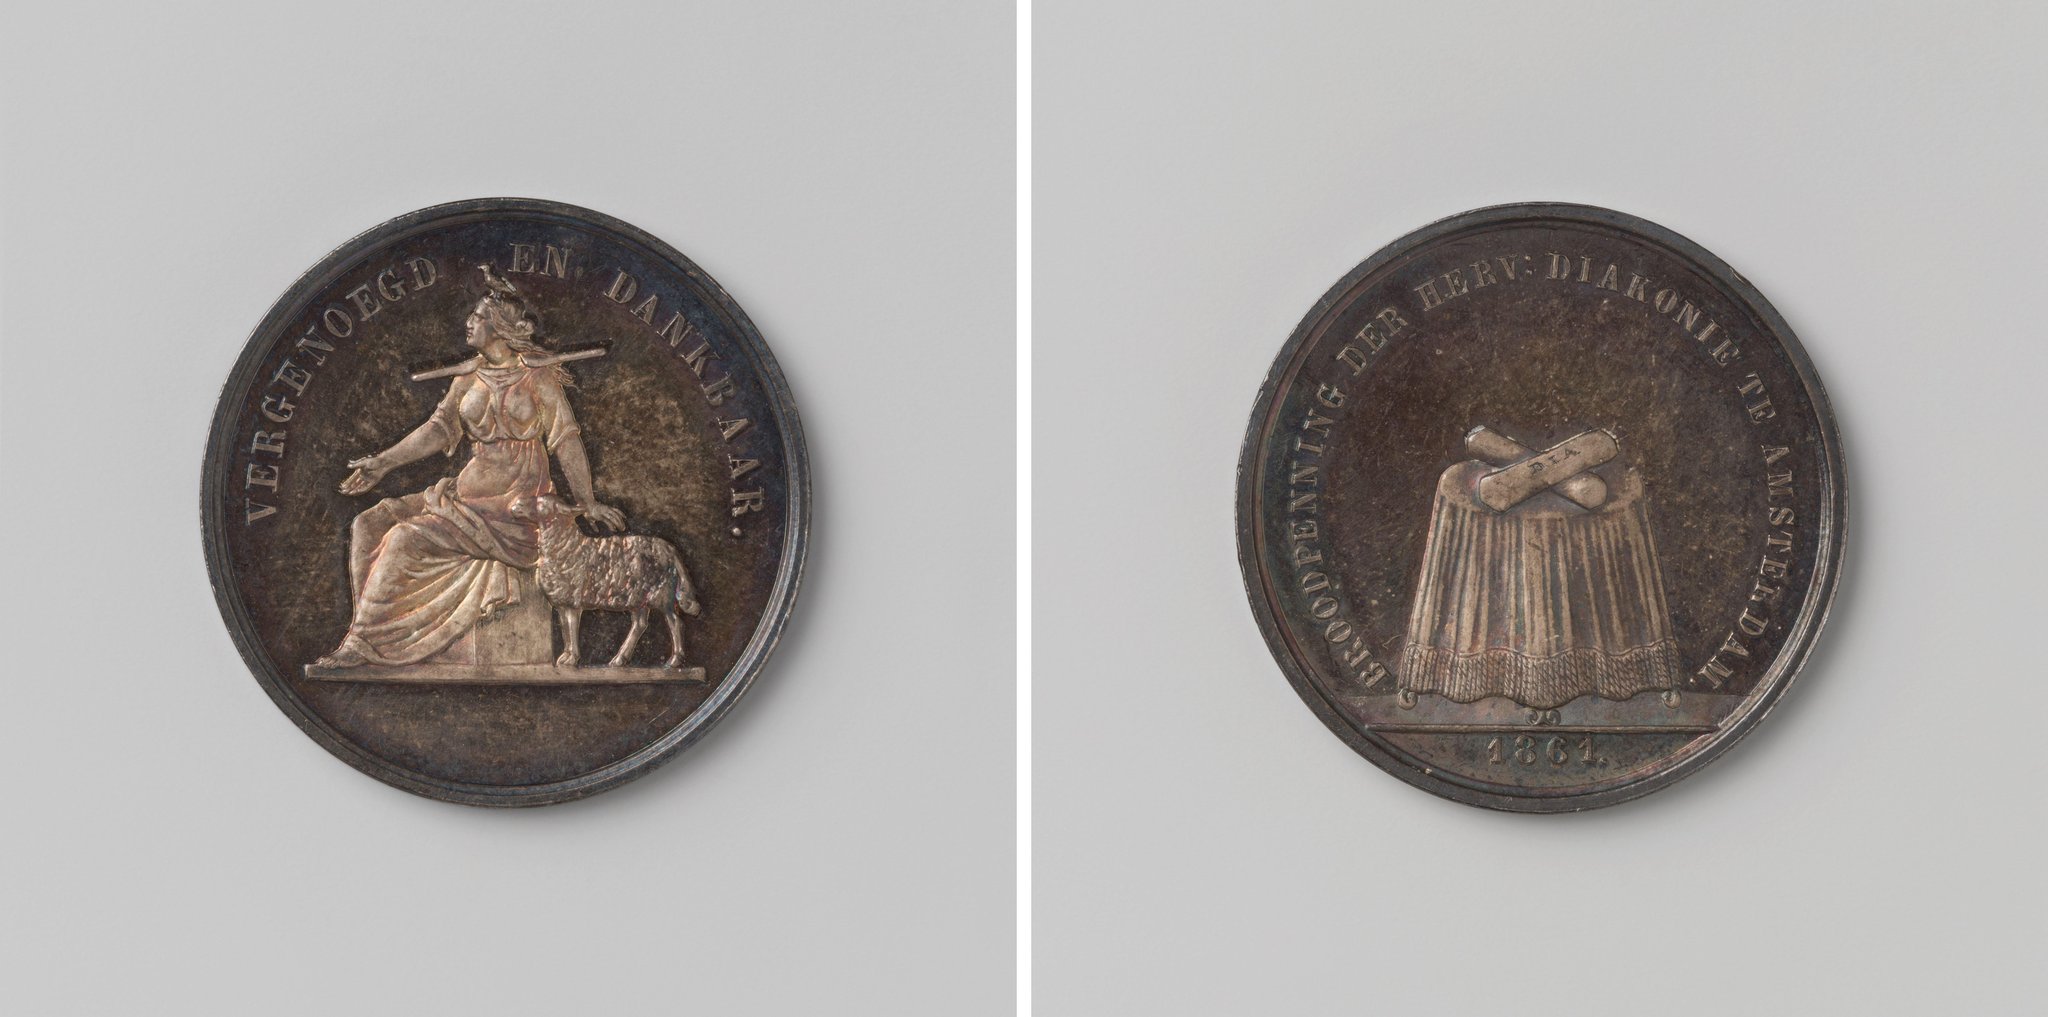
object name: broodpenning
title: Hervormde Diakonie te Amsterdam, penning in de vorm van een armenpenning, geschonken aan nieuw aangekomen diakenen en diakenessen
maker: david van der kellen (1804-1879)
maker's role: die cutter, draughtsman, print maker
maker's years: 1804-1879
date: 1861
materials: silver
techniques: striking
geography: amsterdam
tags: amsterdam